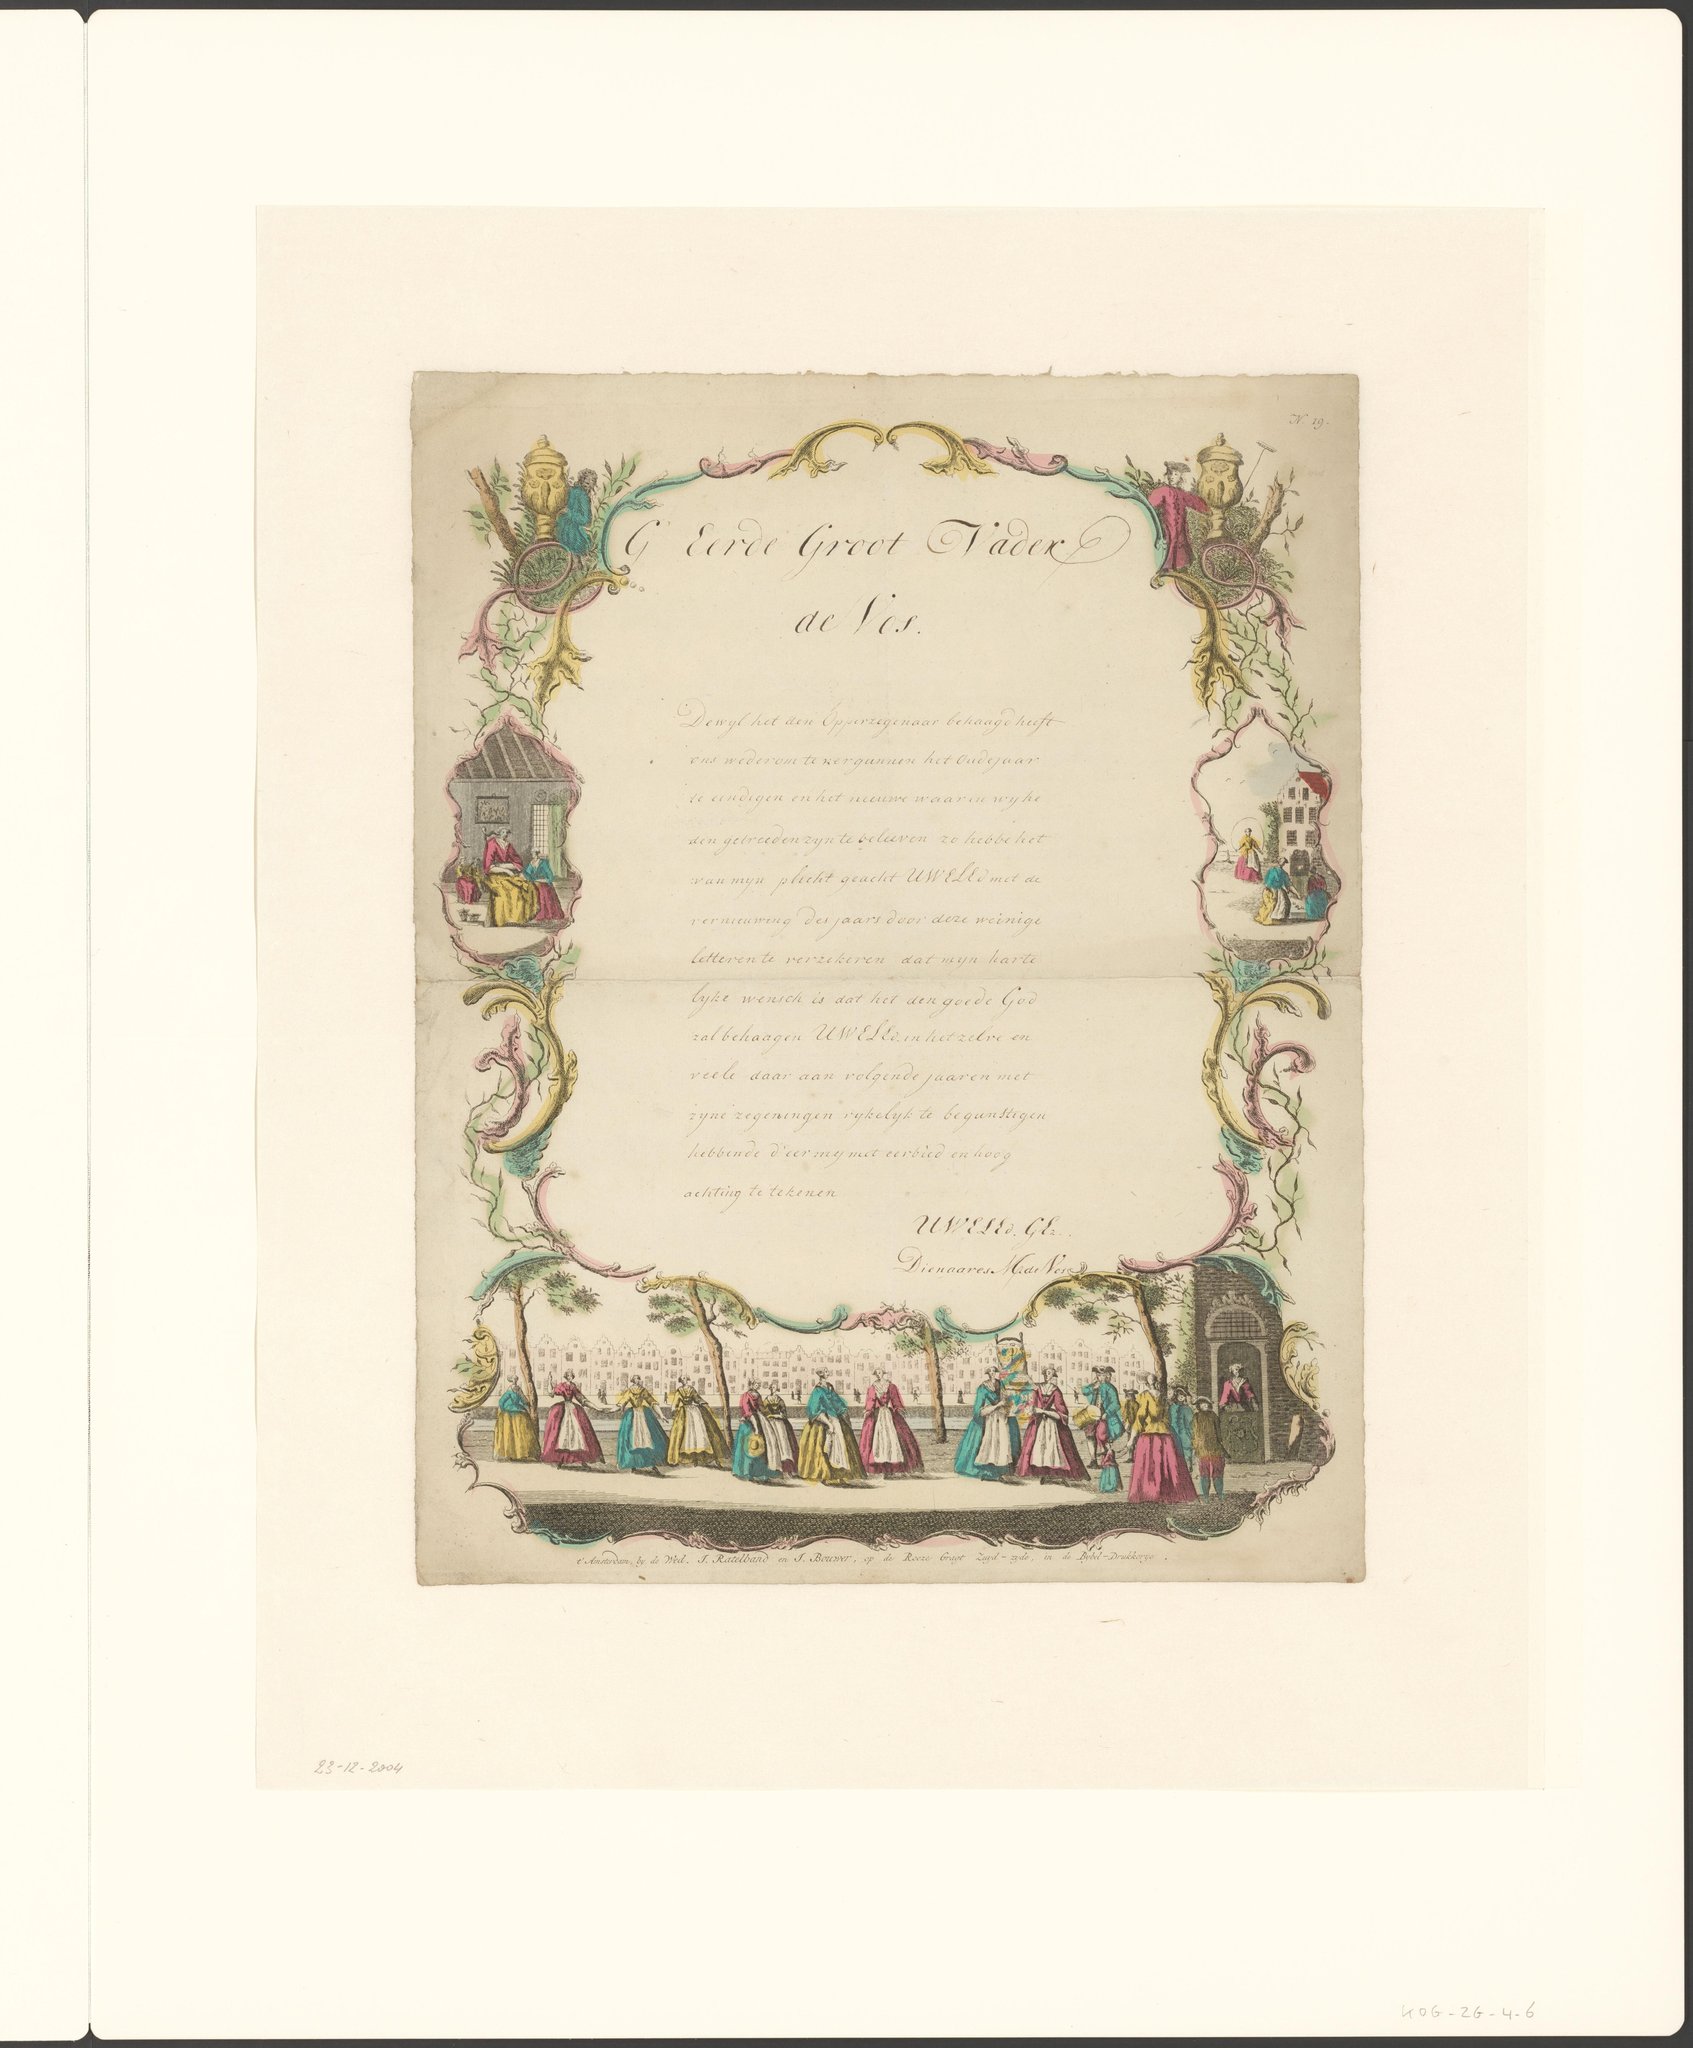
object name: wensbrief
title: Nieuwjaarswens door M. de Vos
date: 1767-1778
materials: ink, paper, watercolor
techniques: brush, etching, hand coloring, pen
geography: netherlands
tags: adolescent, young woman, maiden, girl (child between toddler and youth), january 1 (~ festivities), family life at home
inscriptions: collector's mark: Lugt 1641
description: Nieuwjaarswens door M. de Vos voor haar grootvader De Vos, mogelijk Jacob Willemsz. de Vos. Zonder jaartal. Handschrift binnen een voorgedrukte kader opgebouwd uit voorstellingen uit het dagelijks leven van een meisje of jonge vrouw. Genummerd rechtsboven: N. 19.